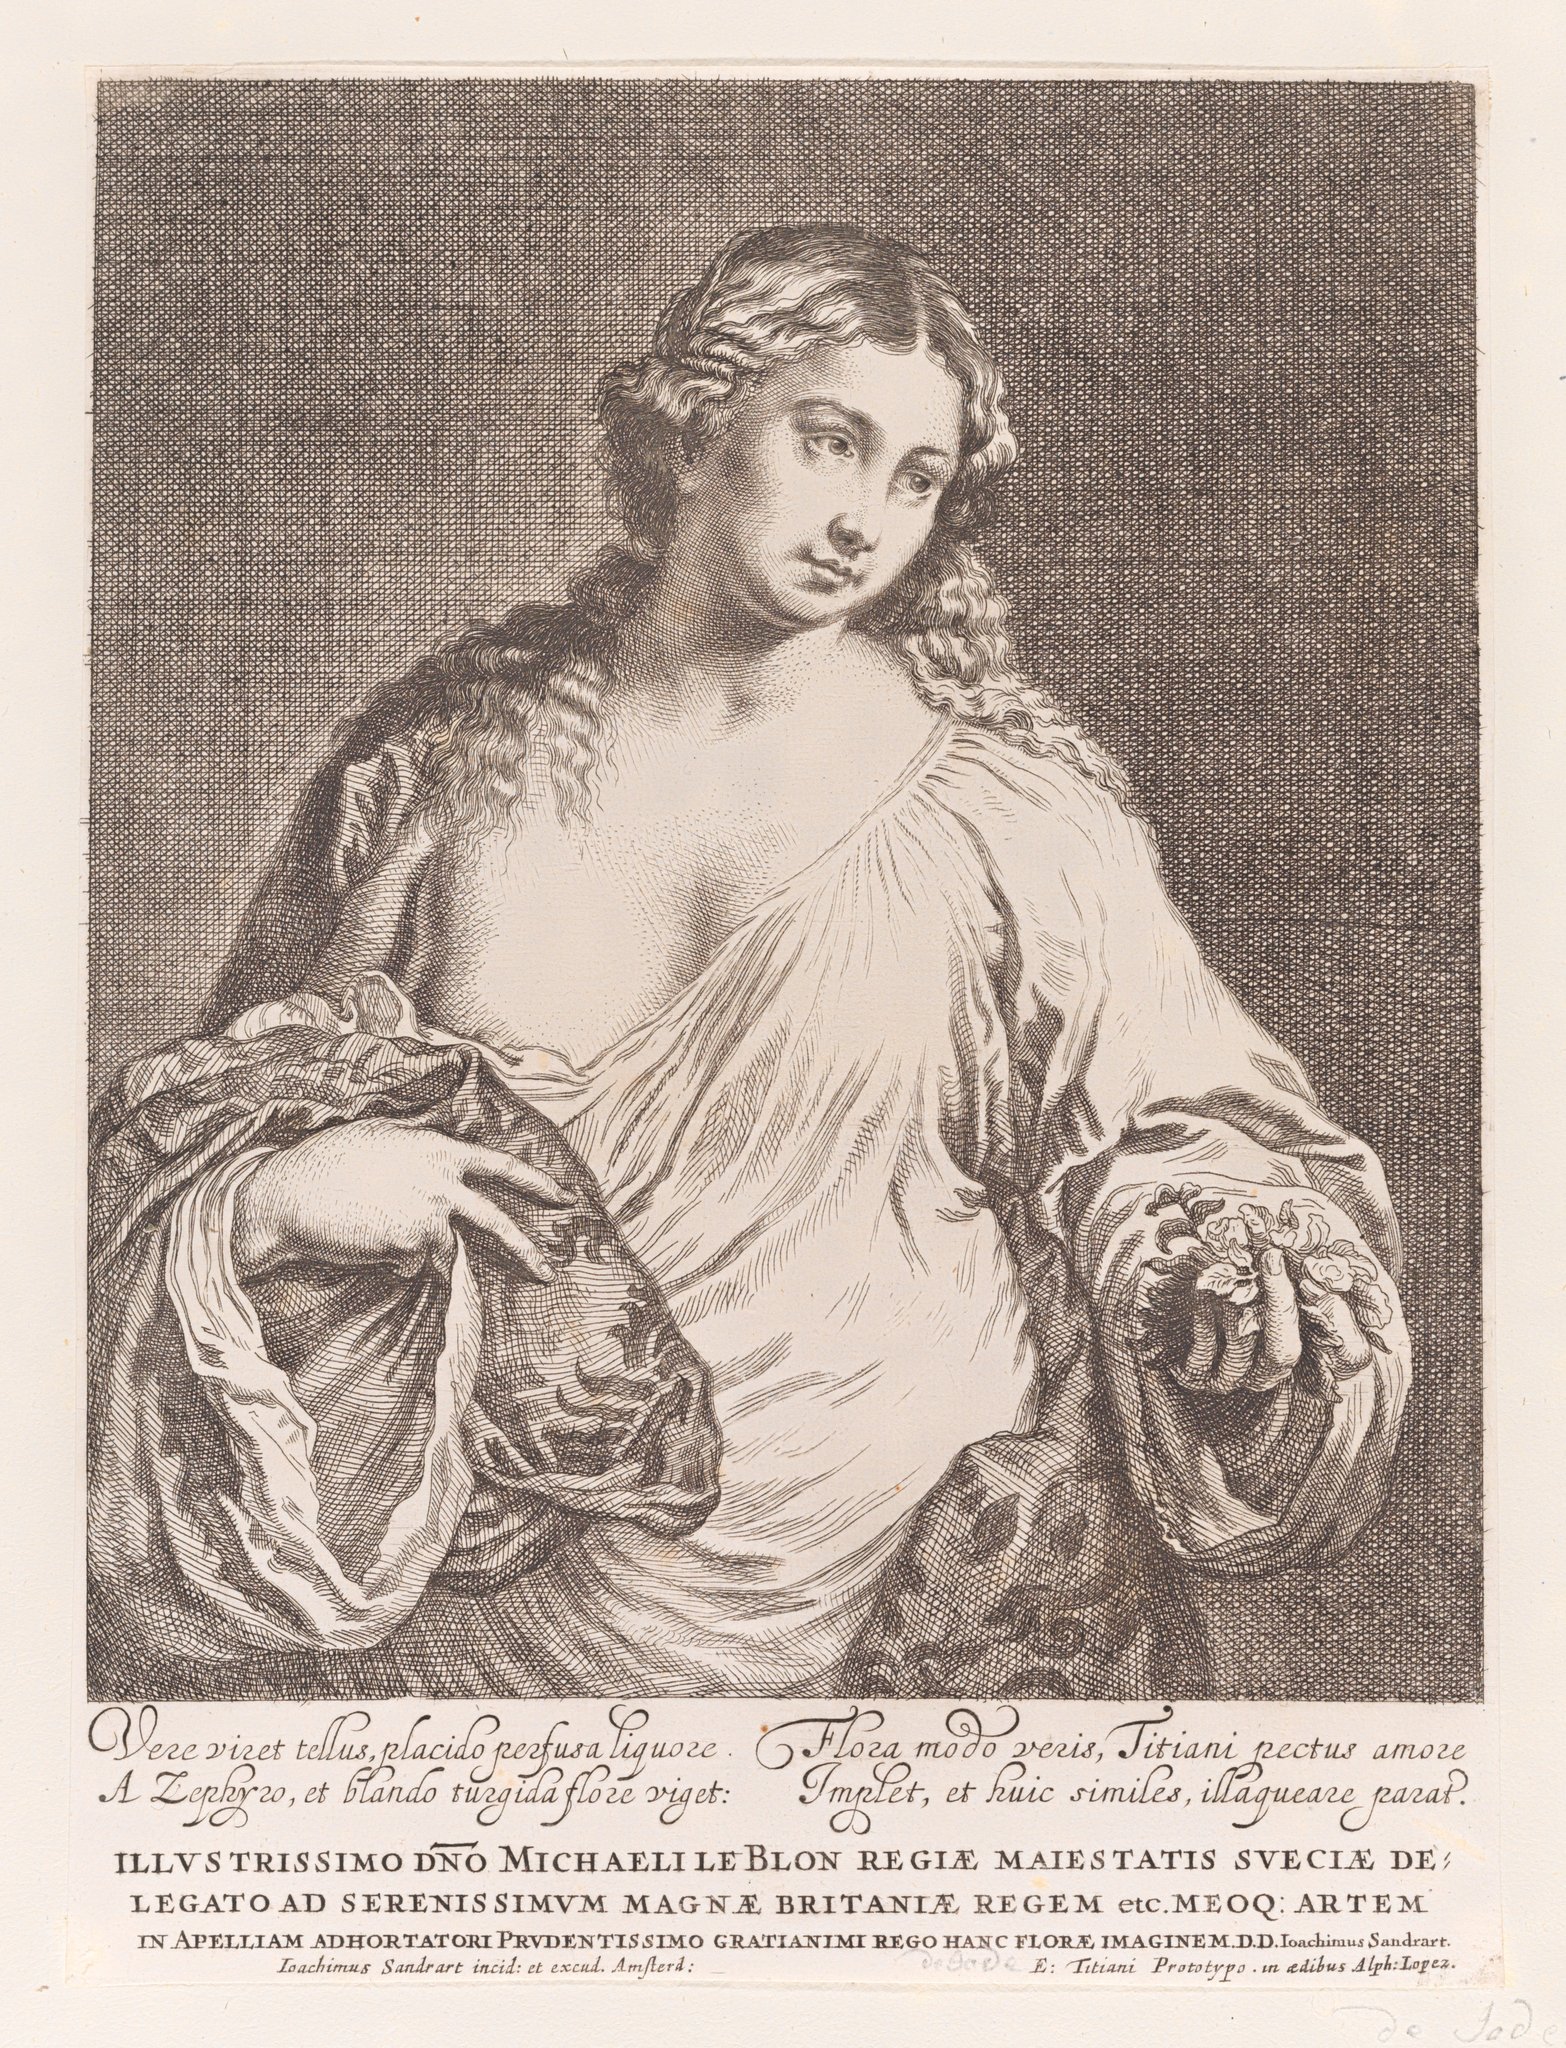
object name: print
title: Flora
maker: joachim von sandrart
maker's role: artist and publisher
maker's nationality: german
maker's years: 1606-1688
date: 1626-1688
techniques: etching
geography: amsterdam